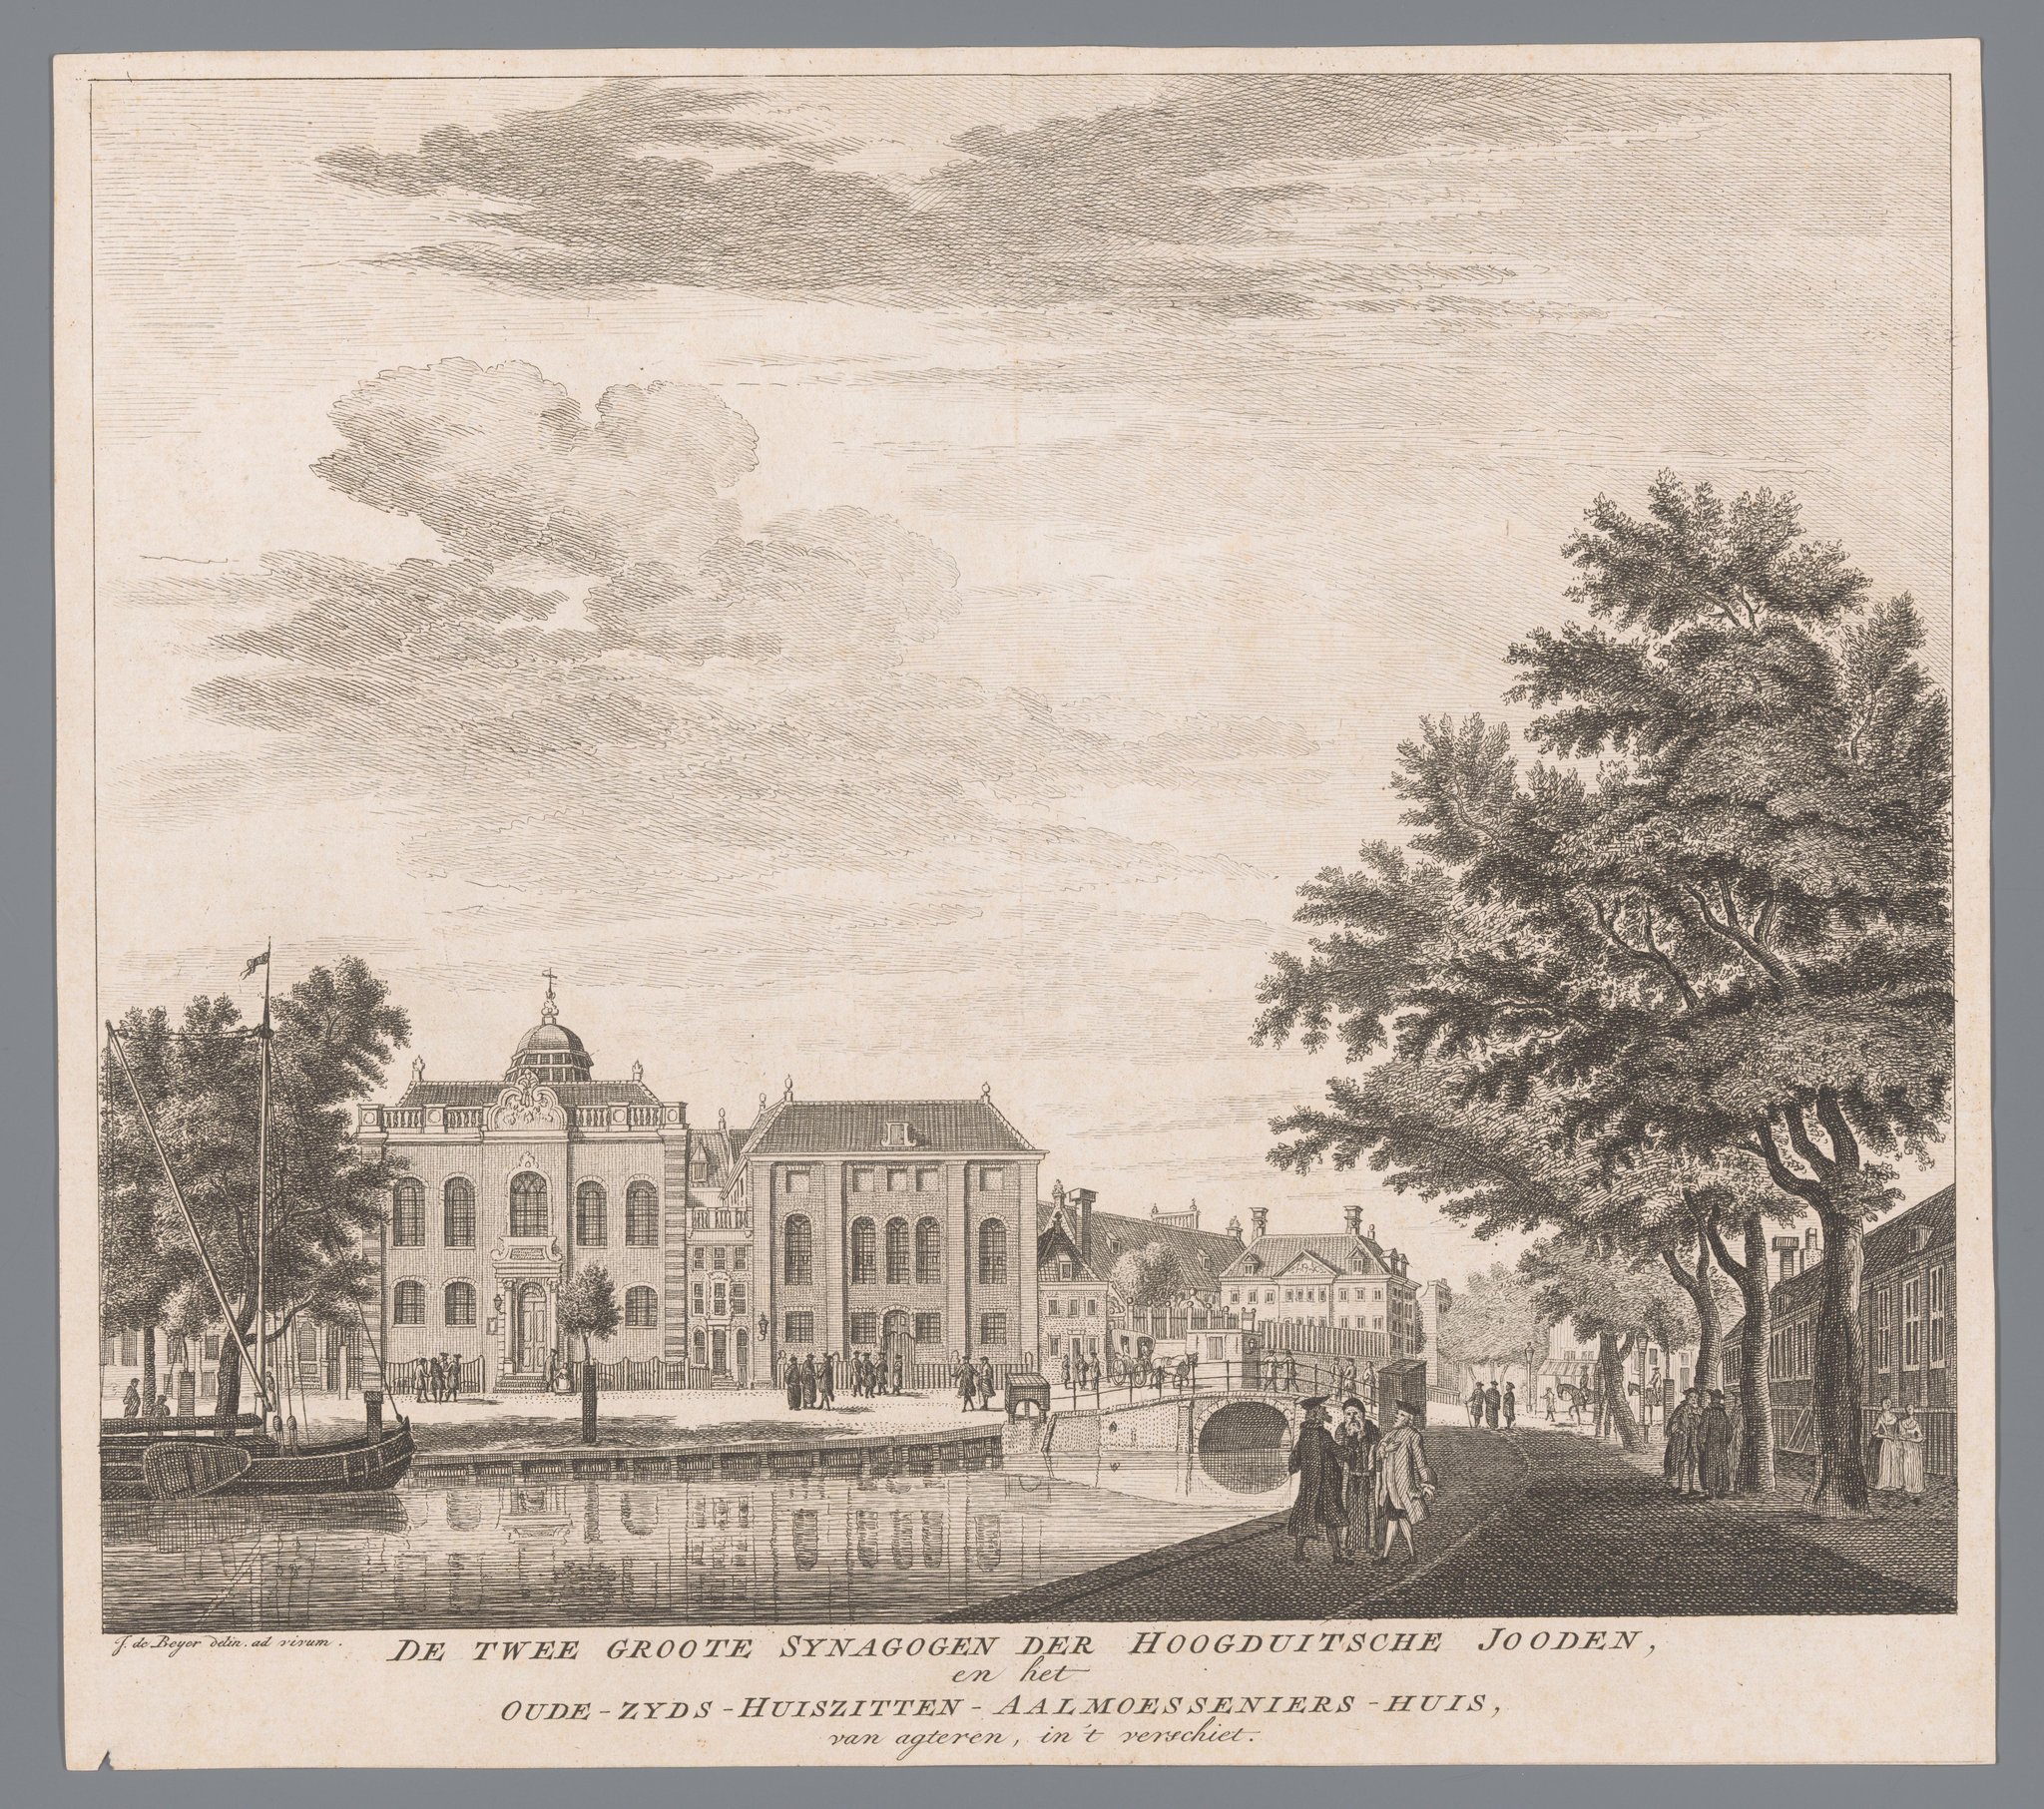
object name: print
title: De twee groote Synagogen der Hoogduitsche Jooden, en het Oude-Zyds-Huiszitten-Aalmoesseniers-Huis, van agteren, in 't verschiet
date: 1718-1830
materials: paper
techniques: etching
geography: amsterdam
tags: the synagogue (as building and place of worship ~ jewish religion), canals, waters (in city)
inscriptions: number: ‘282’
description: Links liggen de Nieuwe Synagoge en de Grote Synagoge aan het water. In de verte is de achterzijde van de Oudezijds Huiszittenhuis te zien.